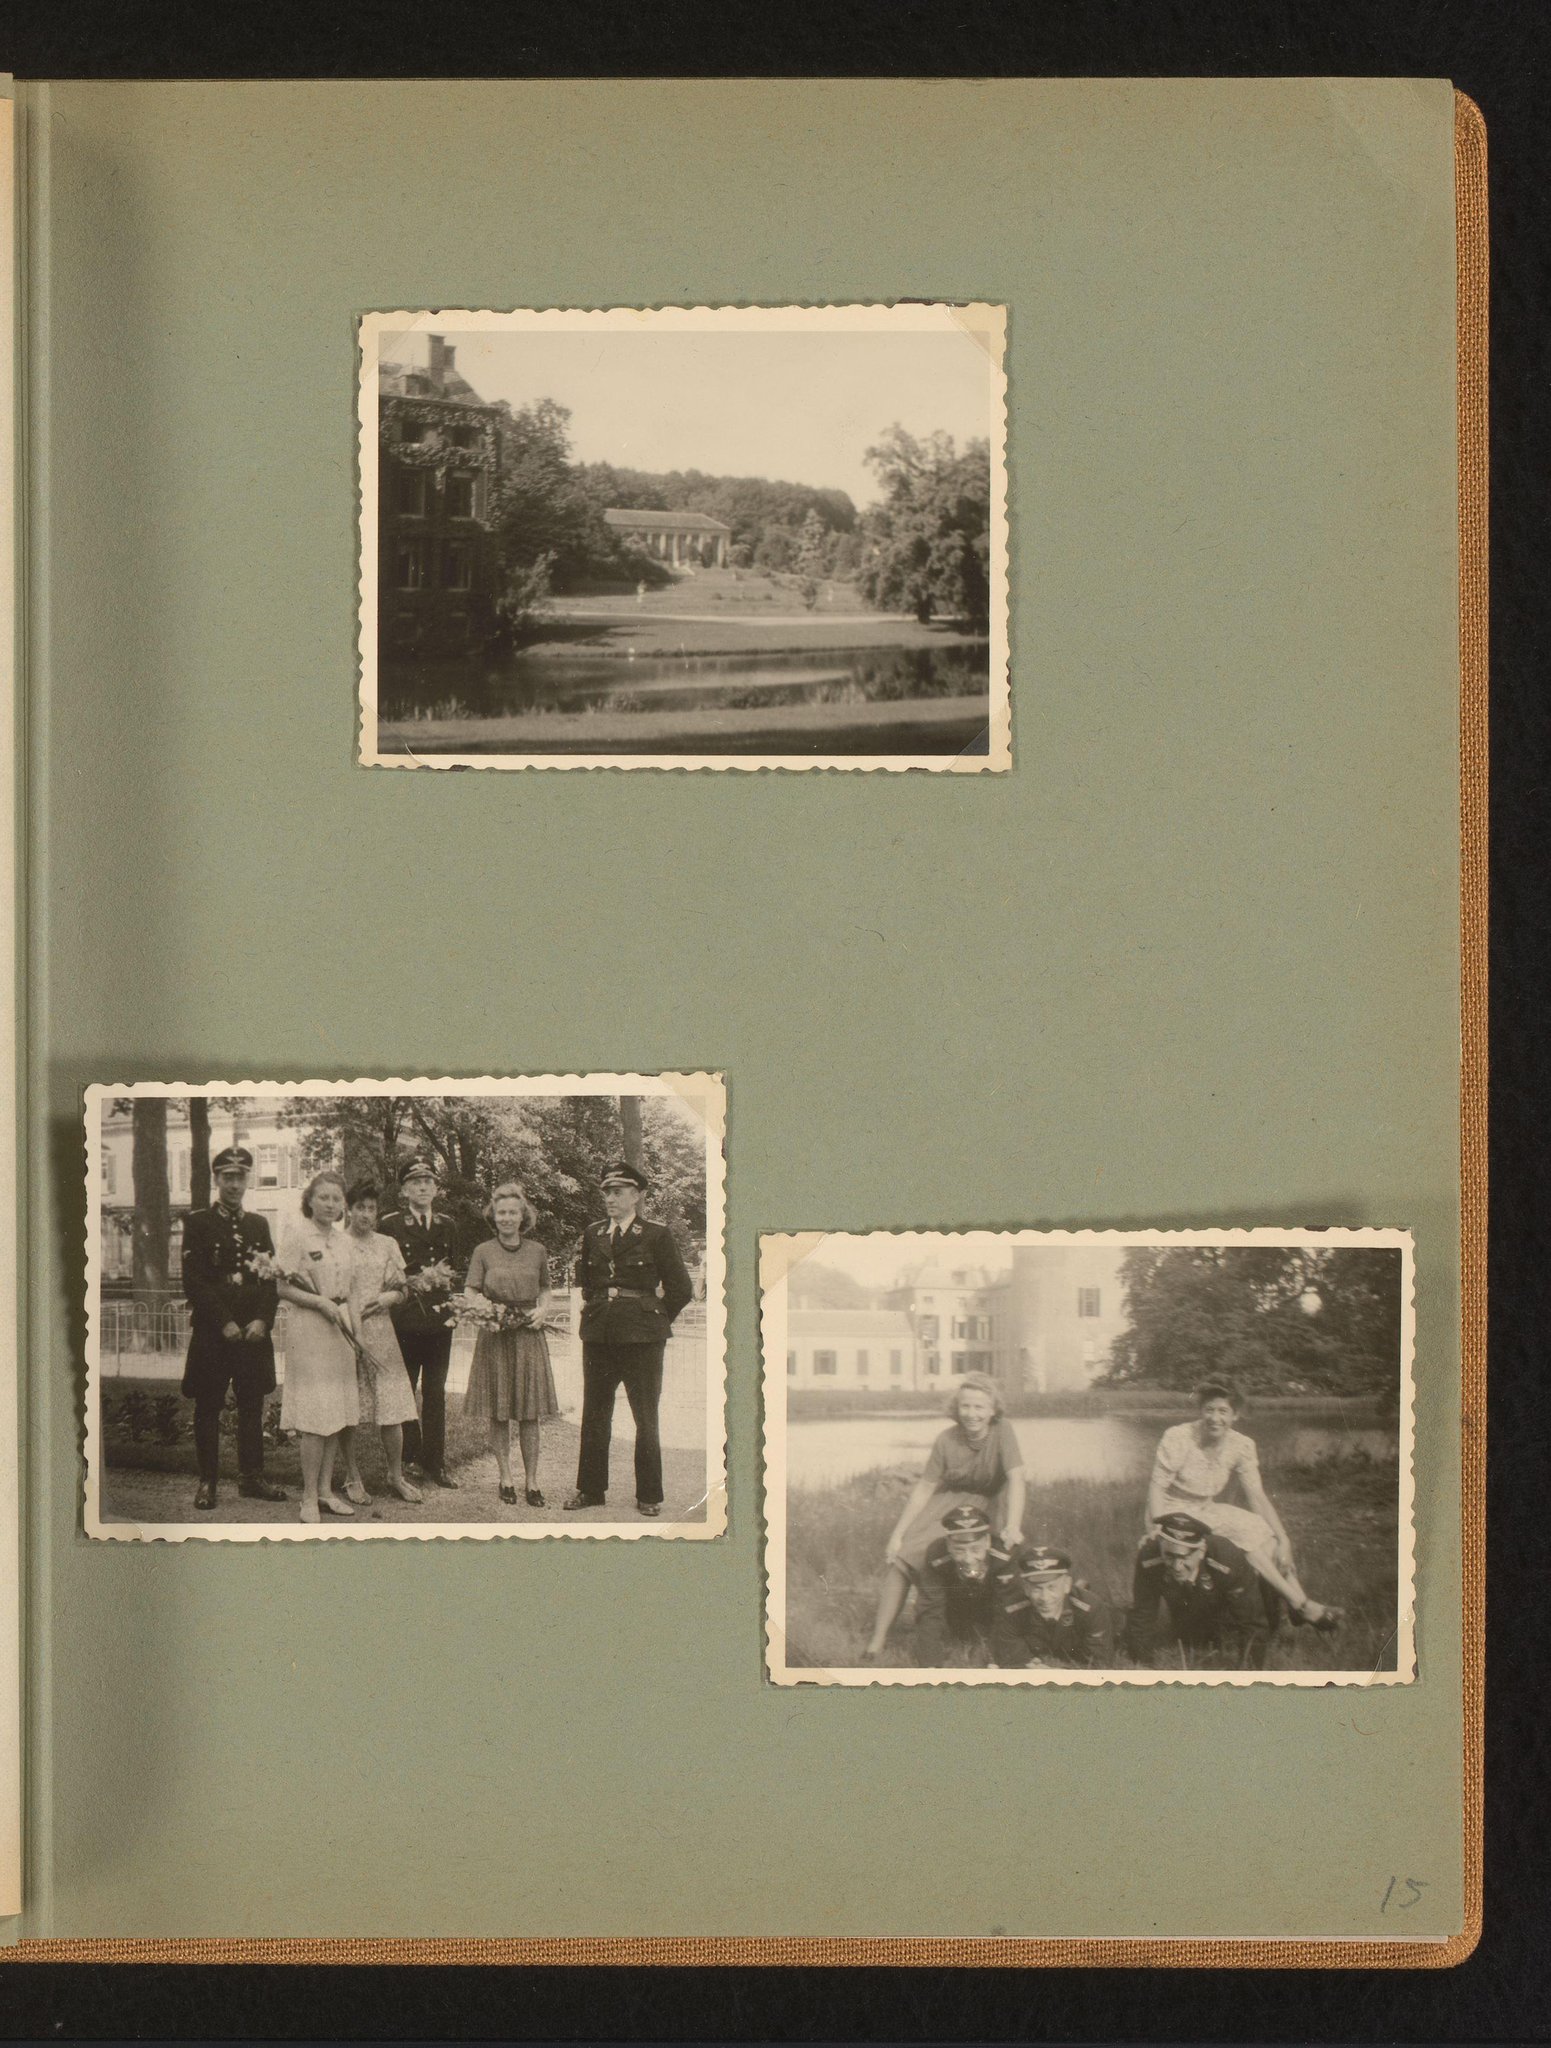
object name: photograph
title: Uitje naar Rozendaal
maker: Anonymous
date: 1944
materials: cardboard, photographic support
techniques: gelatin silver print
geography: rozendaal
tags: outing, pleasure trip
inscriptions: collector's mark: ‘Im Schlosspark zu Velp am 25.6.44’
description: Albumblad met drie foto's gemaakt tijdens een uitje naar Rozendaal (in het opschrift vermeld als Velp), 25 juni 1944. Op enkele van de foto's zijn Hedwig en Käte te herkennen samen met andere officieren van de Deutsche Reichsbahn. Onderdeel van het fotoalbum Deutsche Reichsbahn, 1943-1944.